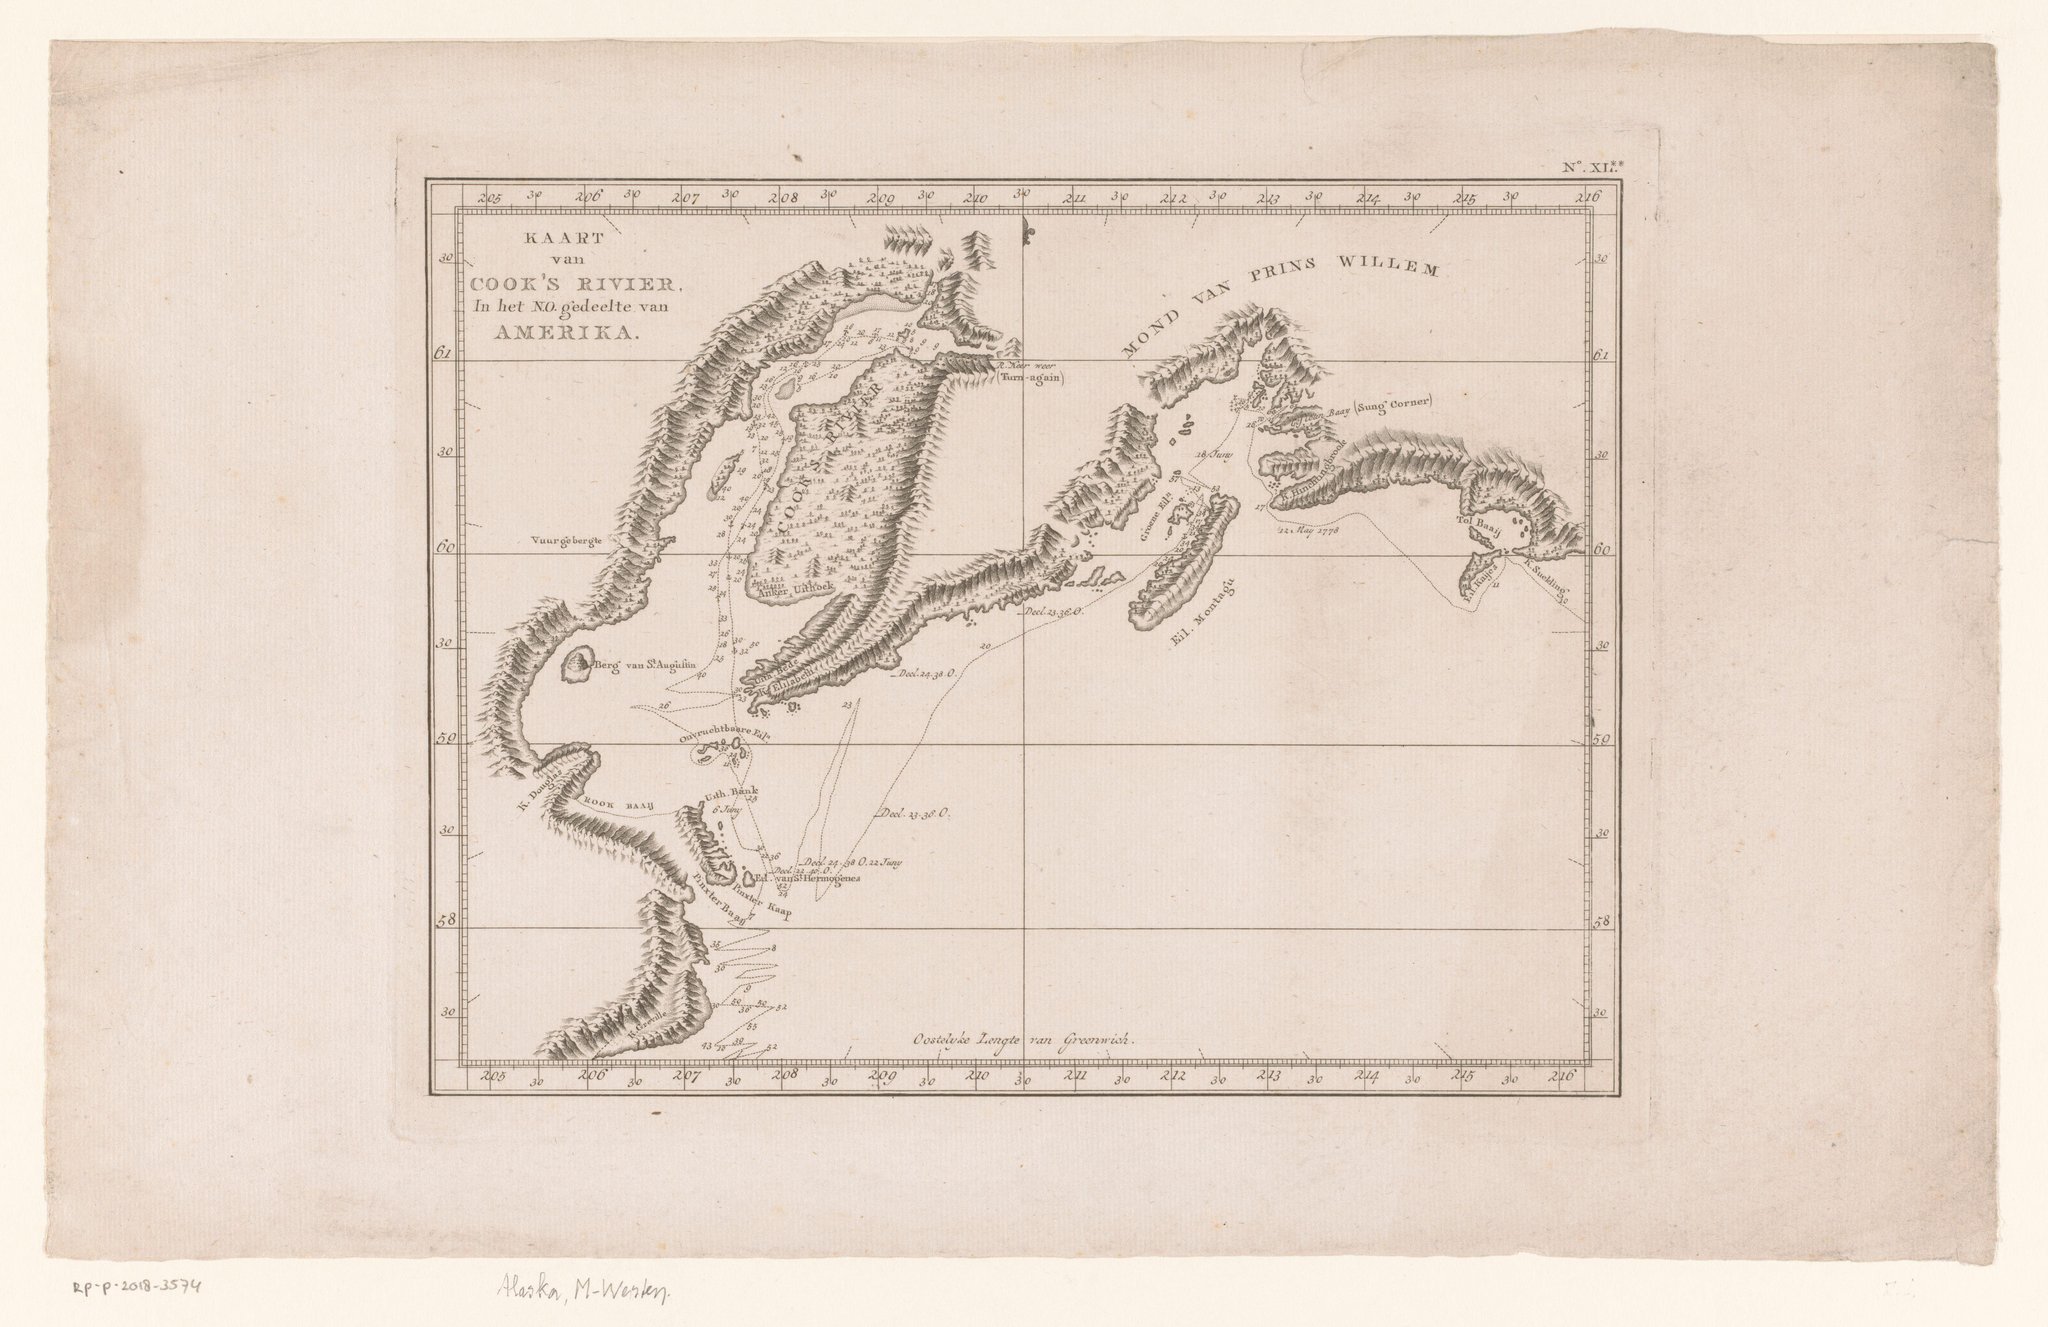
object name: print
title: Kaart van Cooks River, Amerika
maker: Anonymous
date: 1780-1800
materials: paper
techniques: etching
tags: james cook, maps, atlases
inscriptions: collector's mark: Lugt 2228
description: Kaart van Cooks River. De route van de expeditie in 1778 van James Cook is aangegeven. Rondom een gradenverdeling.